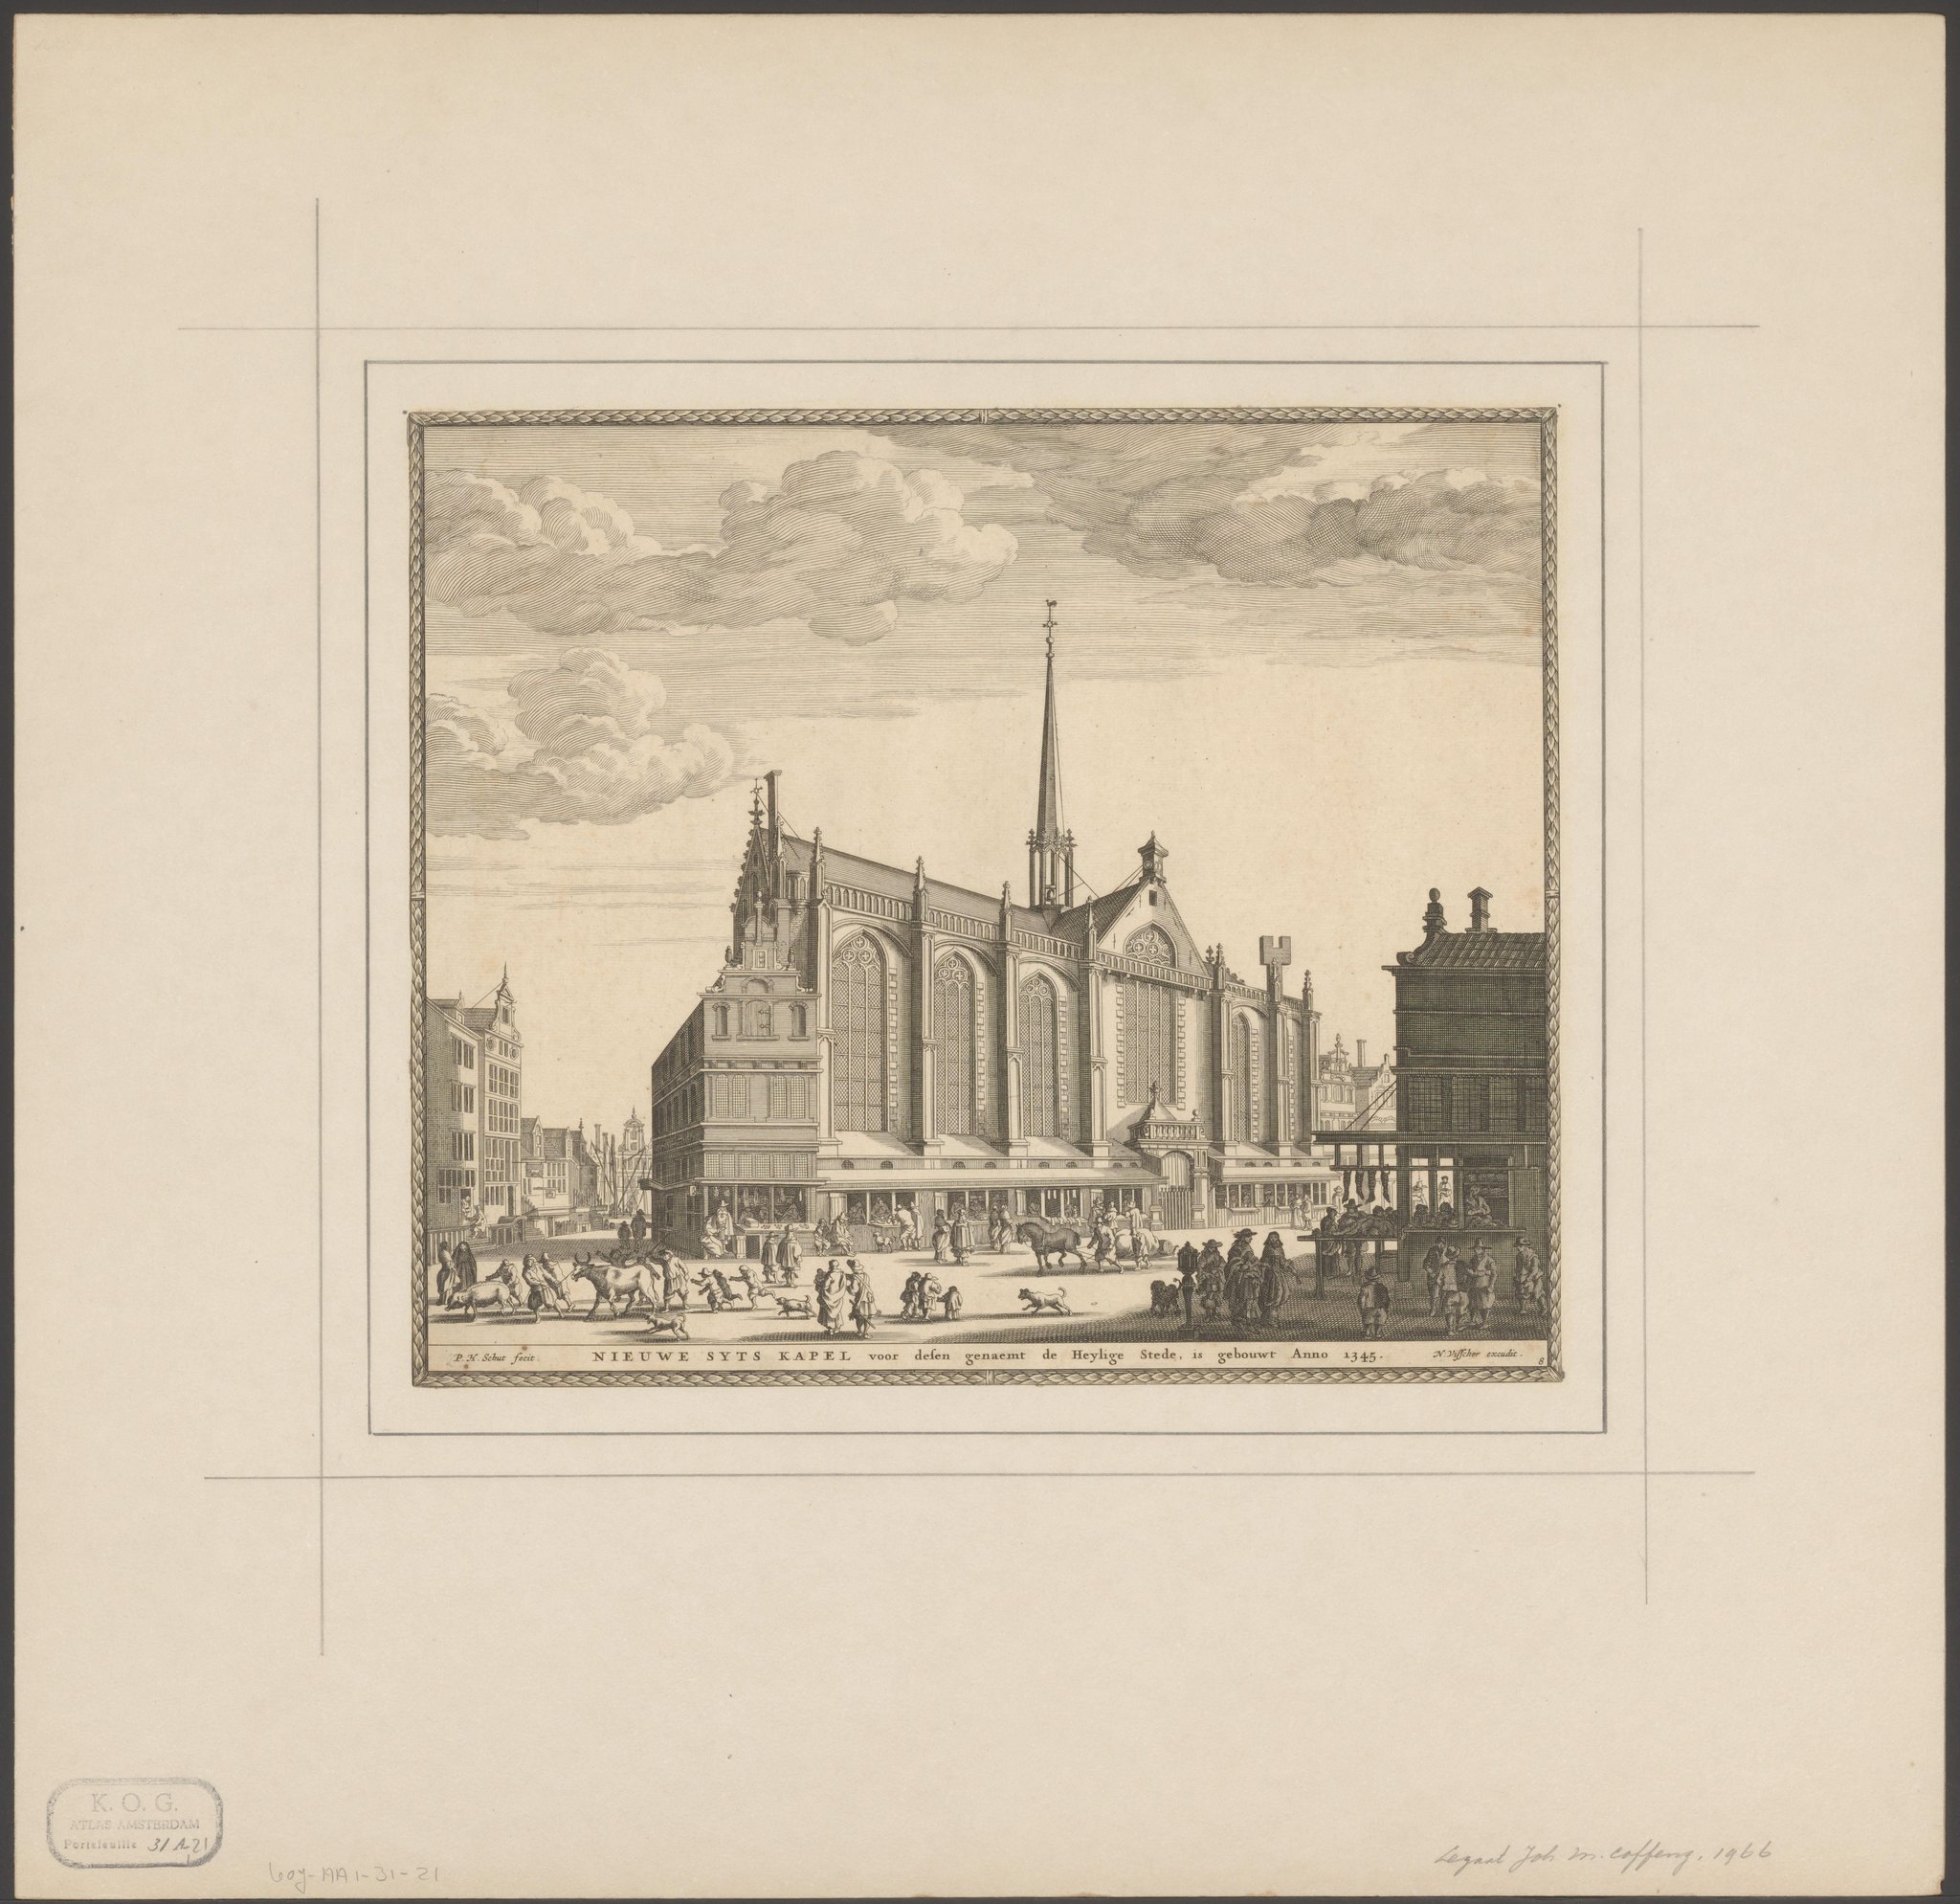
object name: print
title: Nieuwe Syts Kapel voor desen genaemt de Heylige Stede, is gebouwt Anno 1345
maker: pieter hendricksz. schut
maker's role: print maker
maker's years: 1618-1660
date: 1662-1720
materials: paper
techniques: engraving, etching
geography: amsterdam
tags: church (exterior) - qq - small church, chapel, street (+ city(-scape) with figures, staffage)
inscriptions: collector's mark: Lugt 1641b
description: Rechtsonder genummerd: 8. Onderwerpsrubriek binnen de Atlas Amsterdam: Kerkwezen: Hervormde Gemeente: Nieuwezijds Kapel.